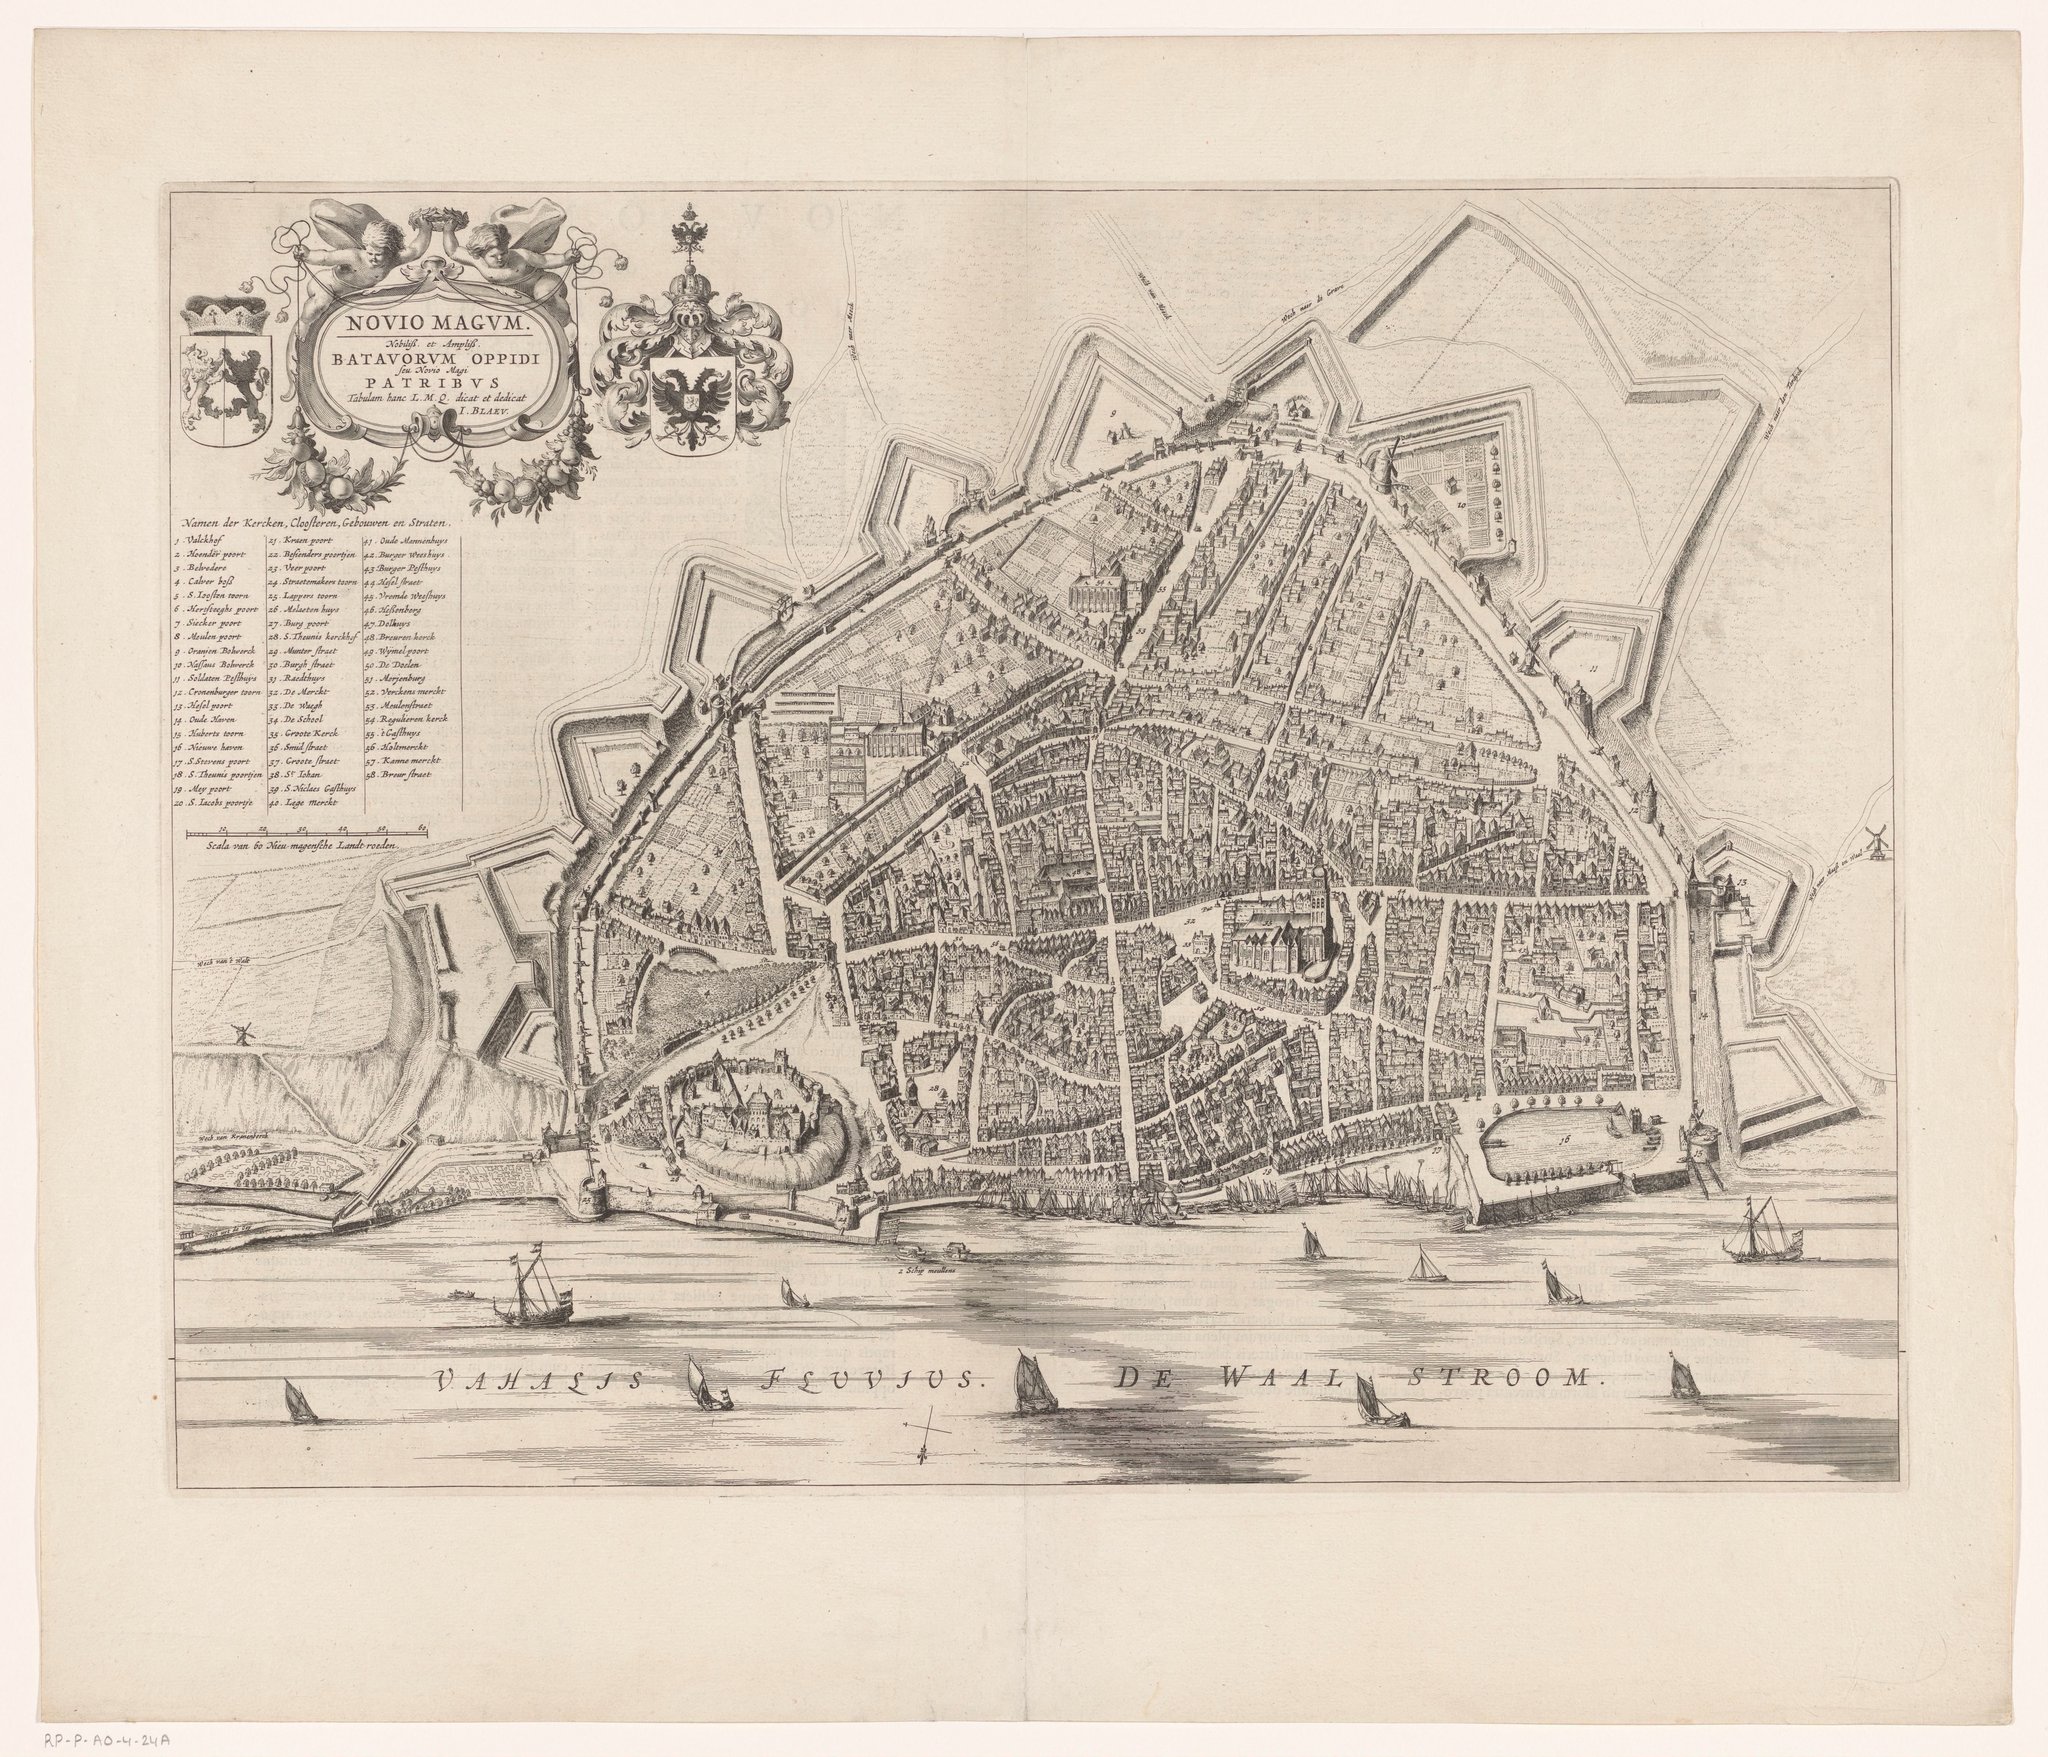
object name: area plan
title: Plattegrond van Nijmegen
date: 1652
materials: paper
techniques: engraving, etching, letterpress printing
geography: nijmegen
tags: coat of arms (as symbol of the state, etc.), maps of cities, nijmegen, gelderland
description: Plattegrond in vogelvluchtperspectief. Linksboven het wapen van Gelderland, een cartouche met titel en opdracht, en het wapen van Nijmegen. Daaronder een legenda en een schaalstok: Scala van 60 Nieu-magensche landt-roeden. Op verso Latijnse tekst.